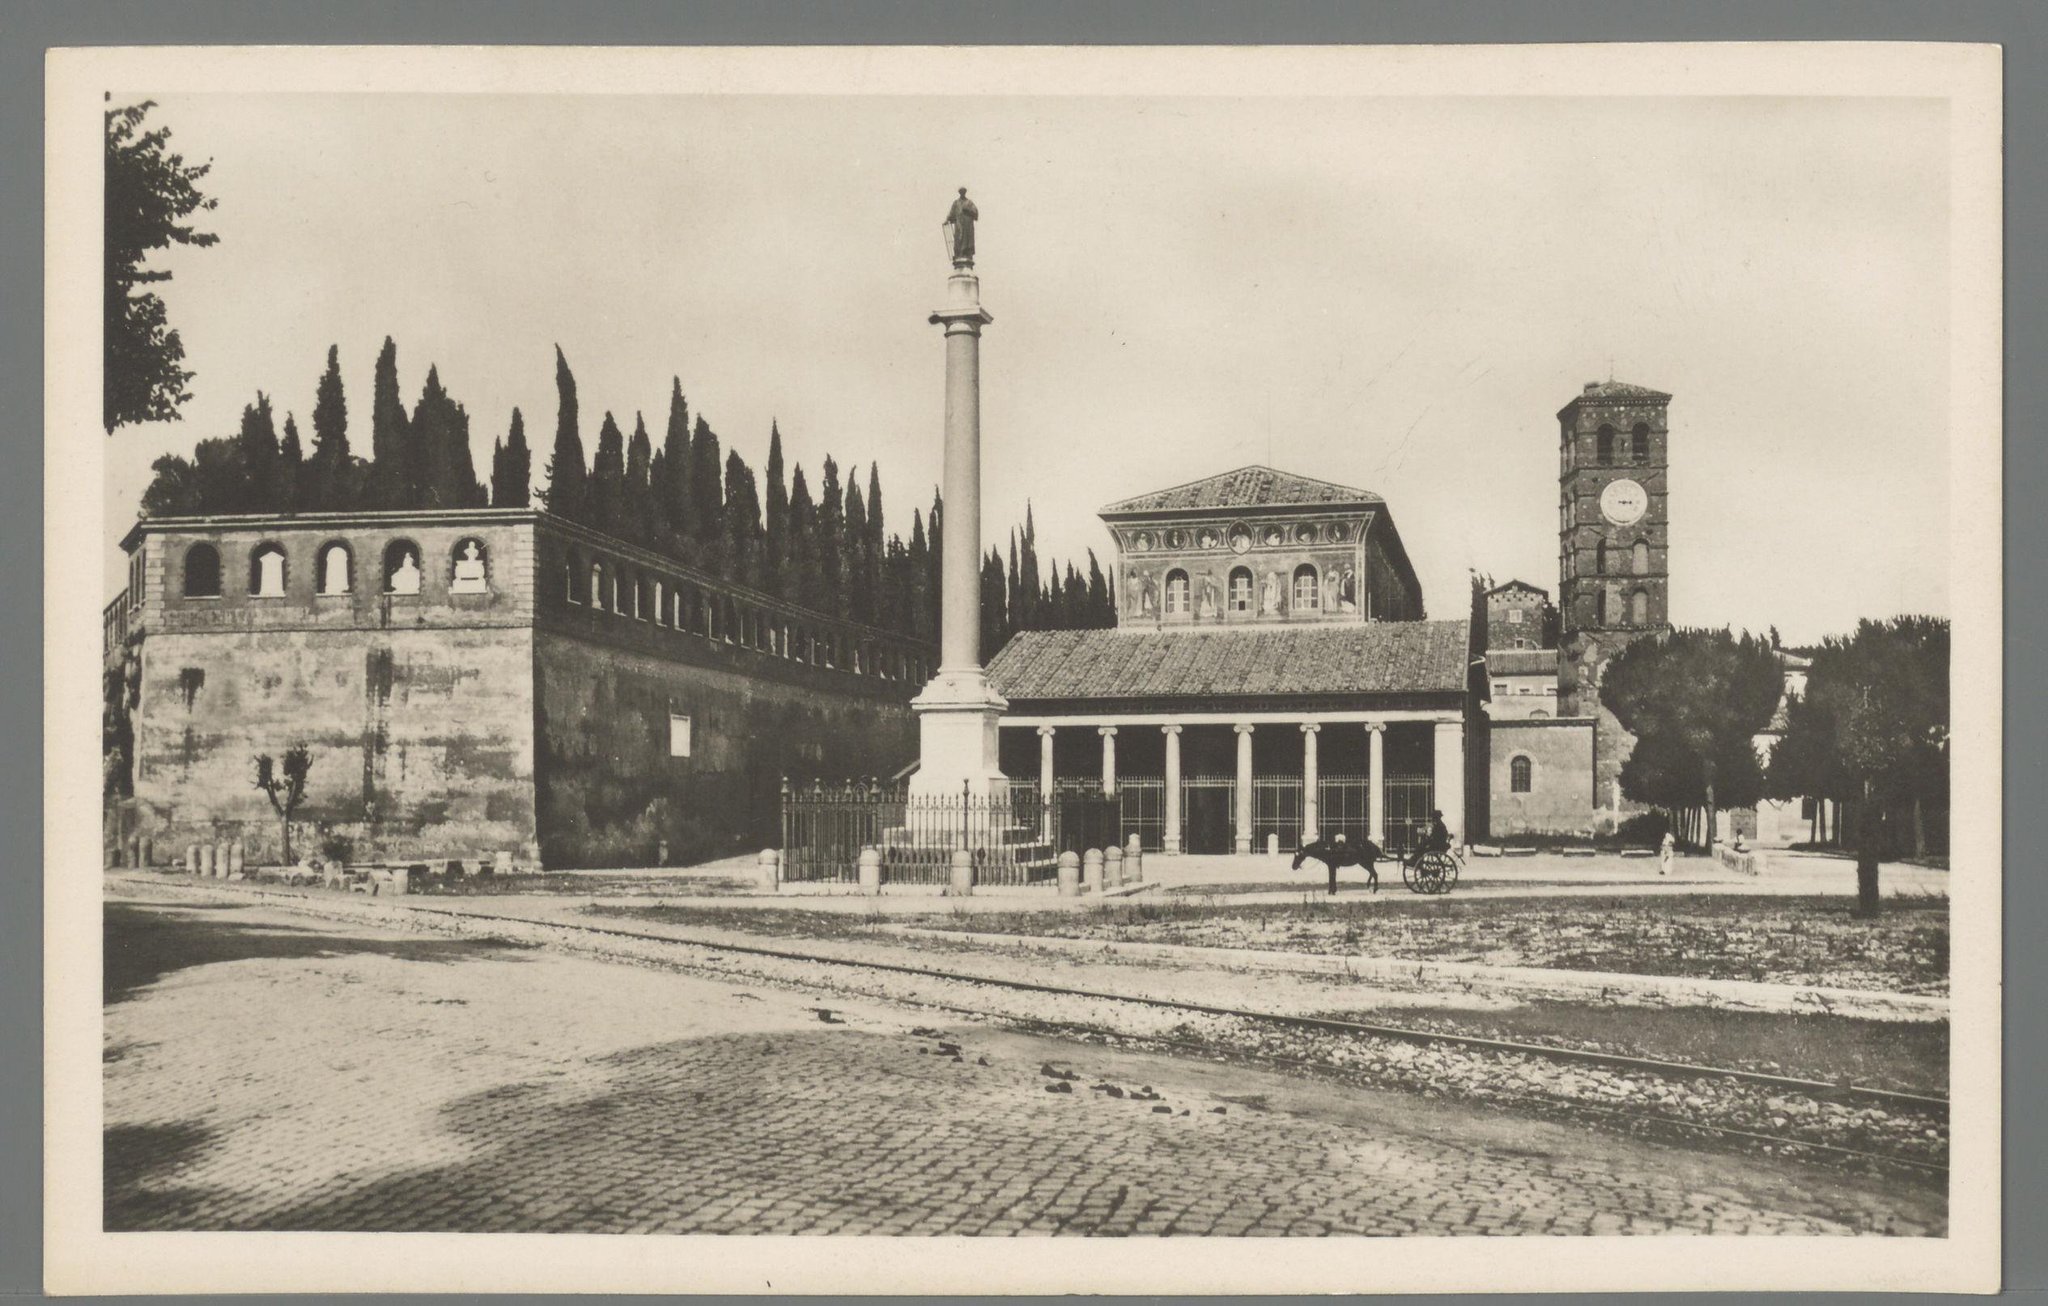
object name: photograph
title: Roma. Basilica di S. Lorenzo fuori le Mura. Facciata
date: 1906-1930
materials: photographic support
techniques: photography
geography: rome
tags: church (exterior), square, place, circus, etc. (+ city(-scape) with figures, staffage)